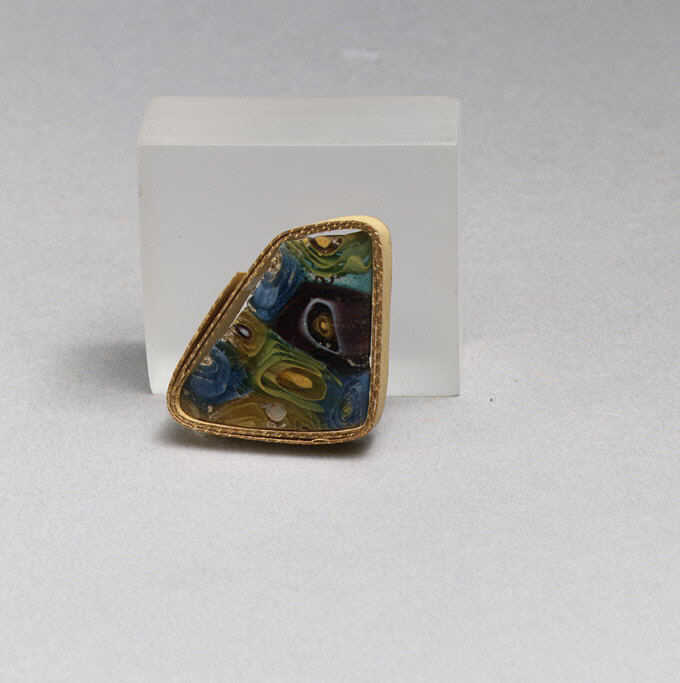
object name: fragment, mosaic bowl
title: Glass mosaic bowl fragment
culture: roman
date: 34 BCE-33 CE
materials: glass